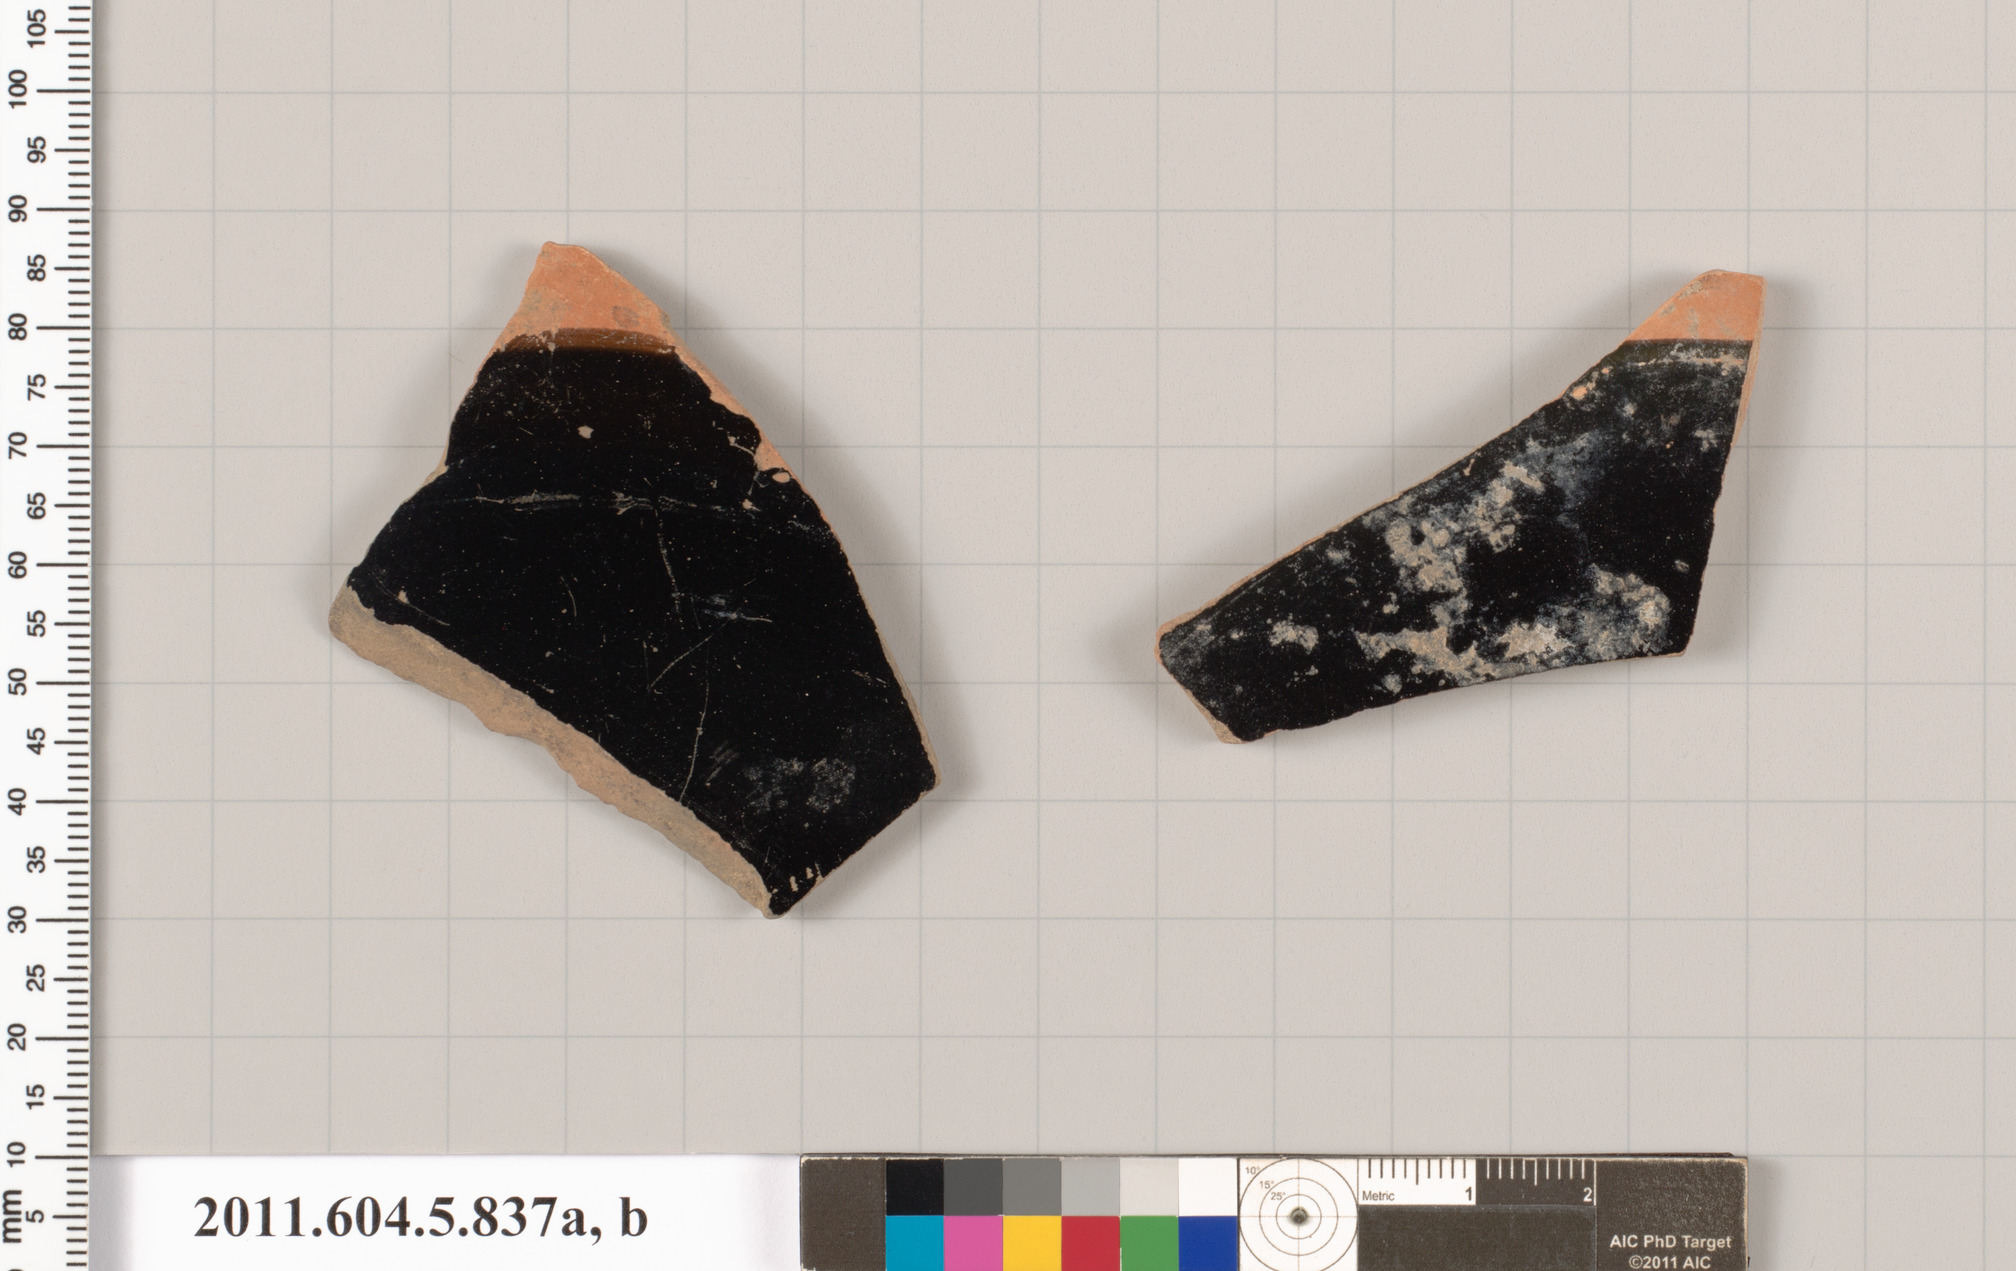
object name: kylix fragment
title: Terracotta fragments of kylikes (drinking cups)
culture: greek, attic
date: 600-401 BCE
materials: terracotta